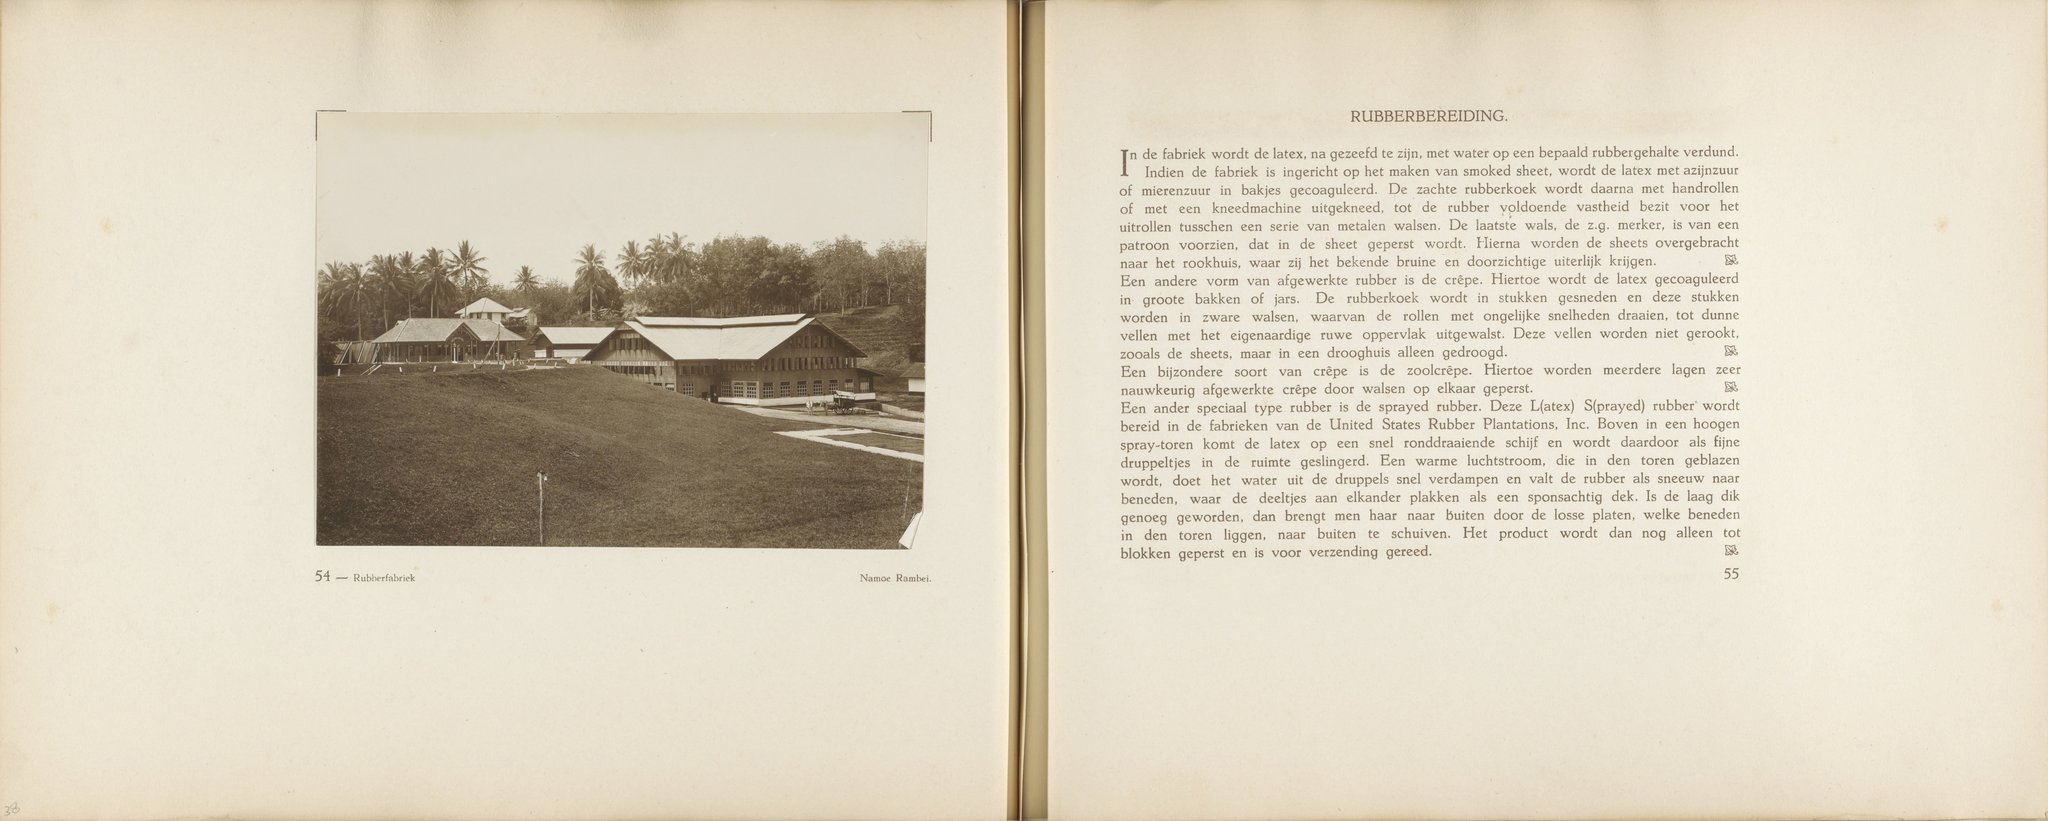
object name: photograph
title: Pagina 54 en 55 van fotoboek van de Algemeene Vereeniging van Rubberplanters ter Oostkust van Sumatra (A.V.R.O.S.)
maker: j.w. meyster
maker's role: fotograaf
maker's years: 1887-1945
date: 1924-1925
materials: paper, photographic support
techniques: printing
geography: sumatra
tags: (non-fruit) products of plants or trees: rubber, factory in landscape, sumatra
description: Twee boekpagina's met links een foto van het exterieur van een rubberfabriek van de Algemeene Vereeniging van Rubberplanters ter Oostkust van Sumatra (A.V.R.O.S.) te Namoe Rambei en rechts informatie over de rubberbereiding. Onderdeel van een fotoboek van de Algemeene Vereeniging van Rubberplanters ter Oostkust van Sumatra (A.V.R.O.S.).